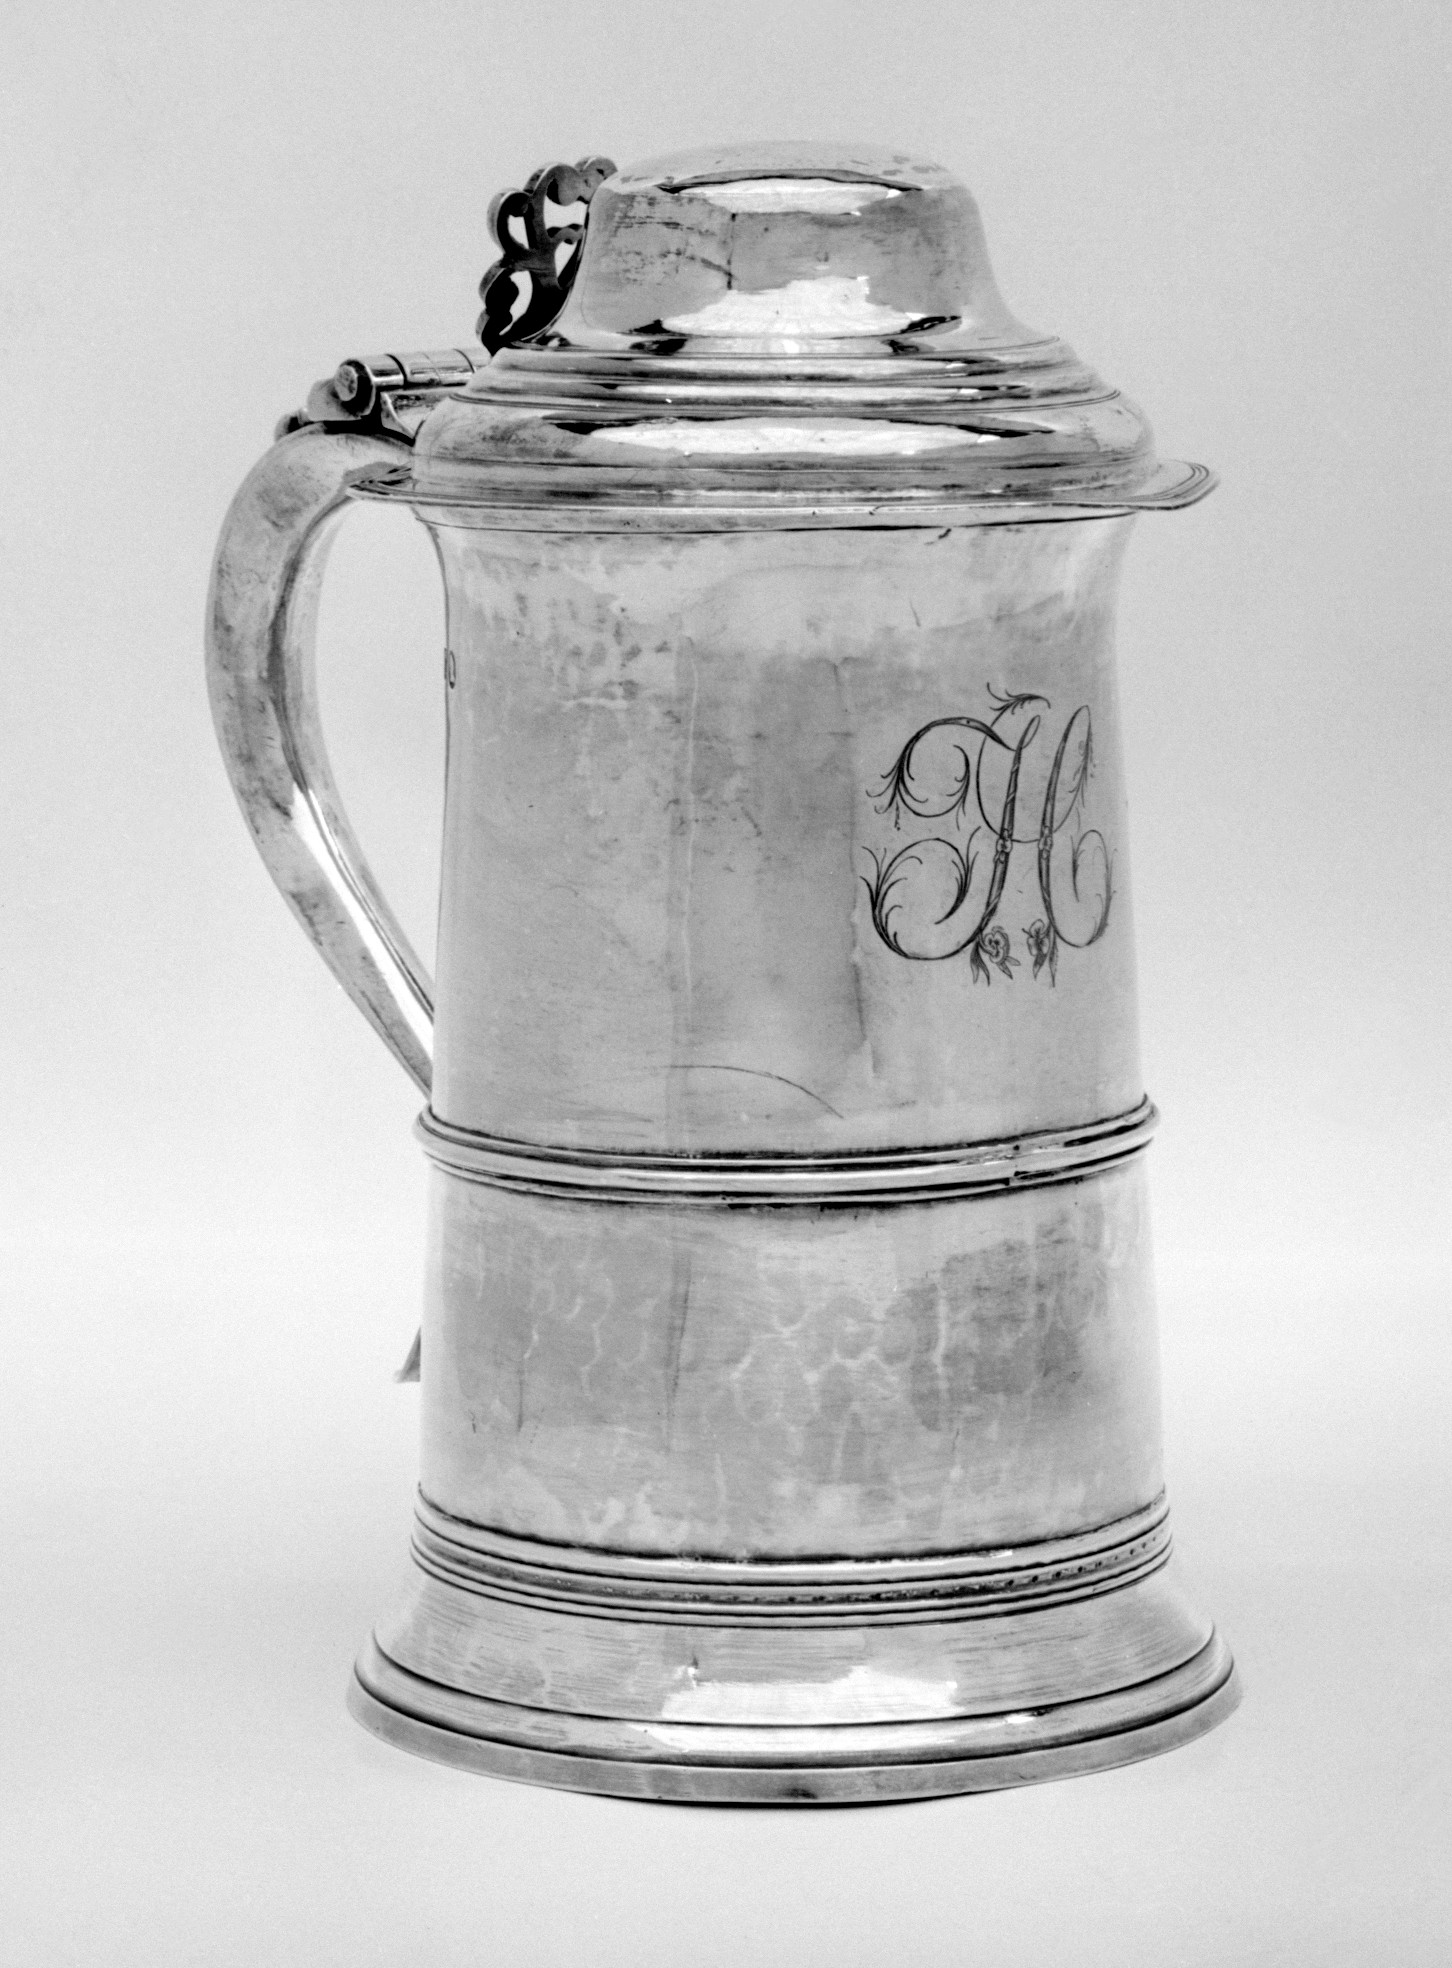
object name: tankard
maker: george giles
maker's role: maker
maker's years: 1762-1773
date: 1792-1793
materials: silver